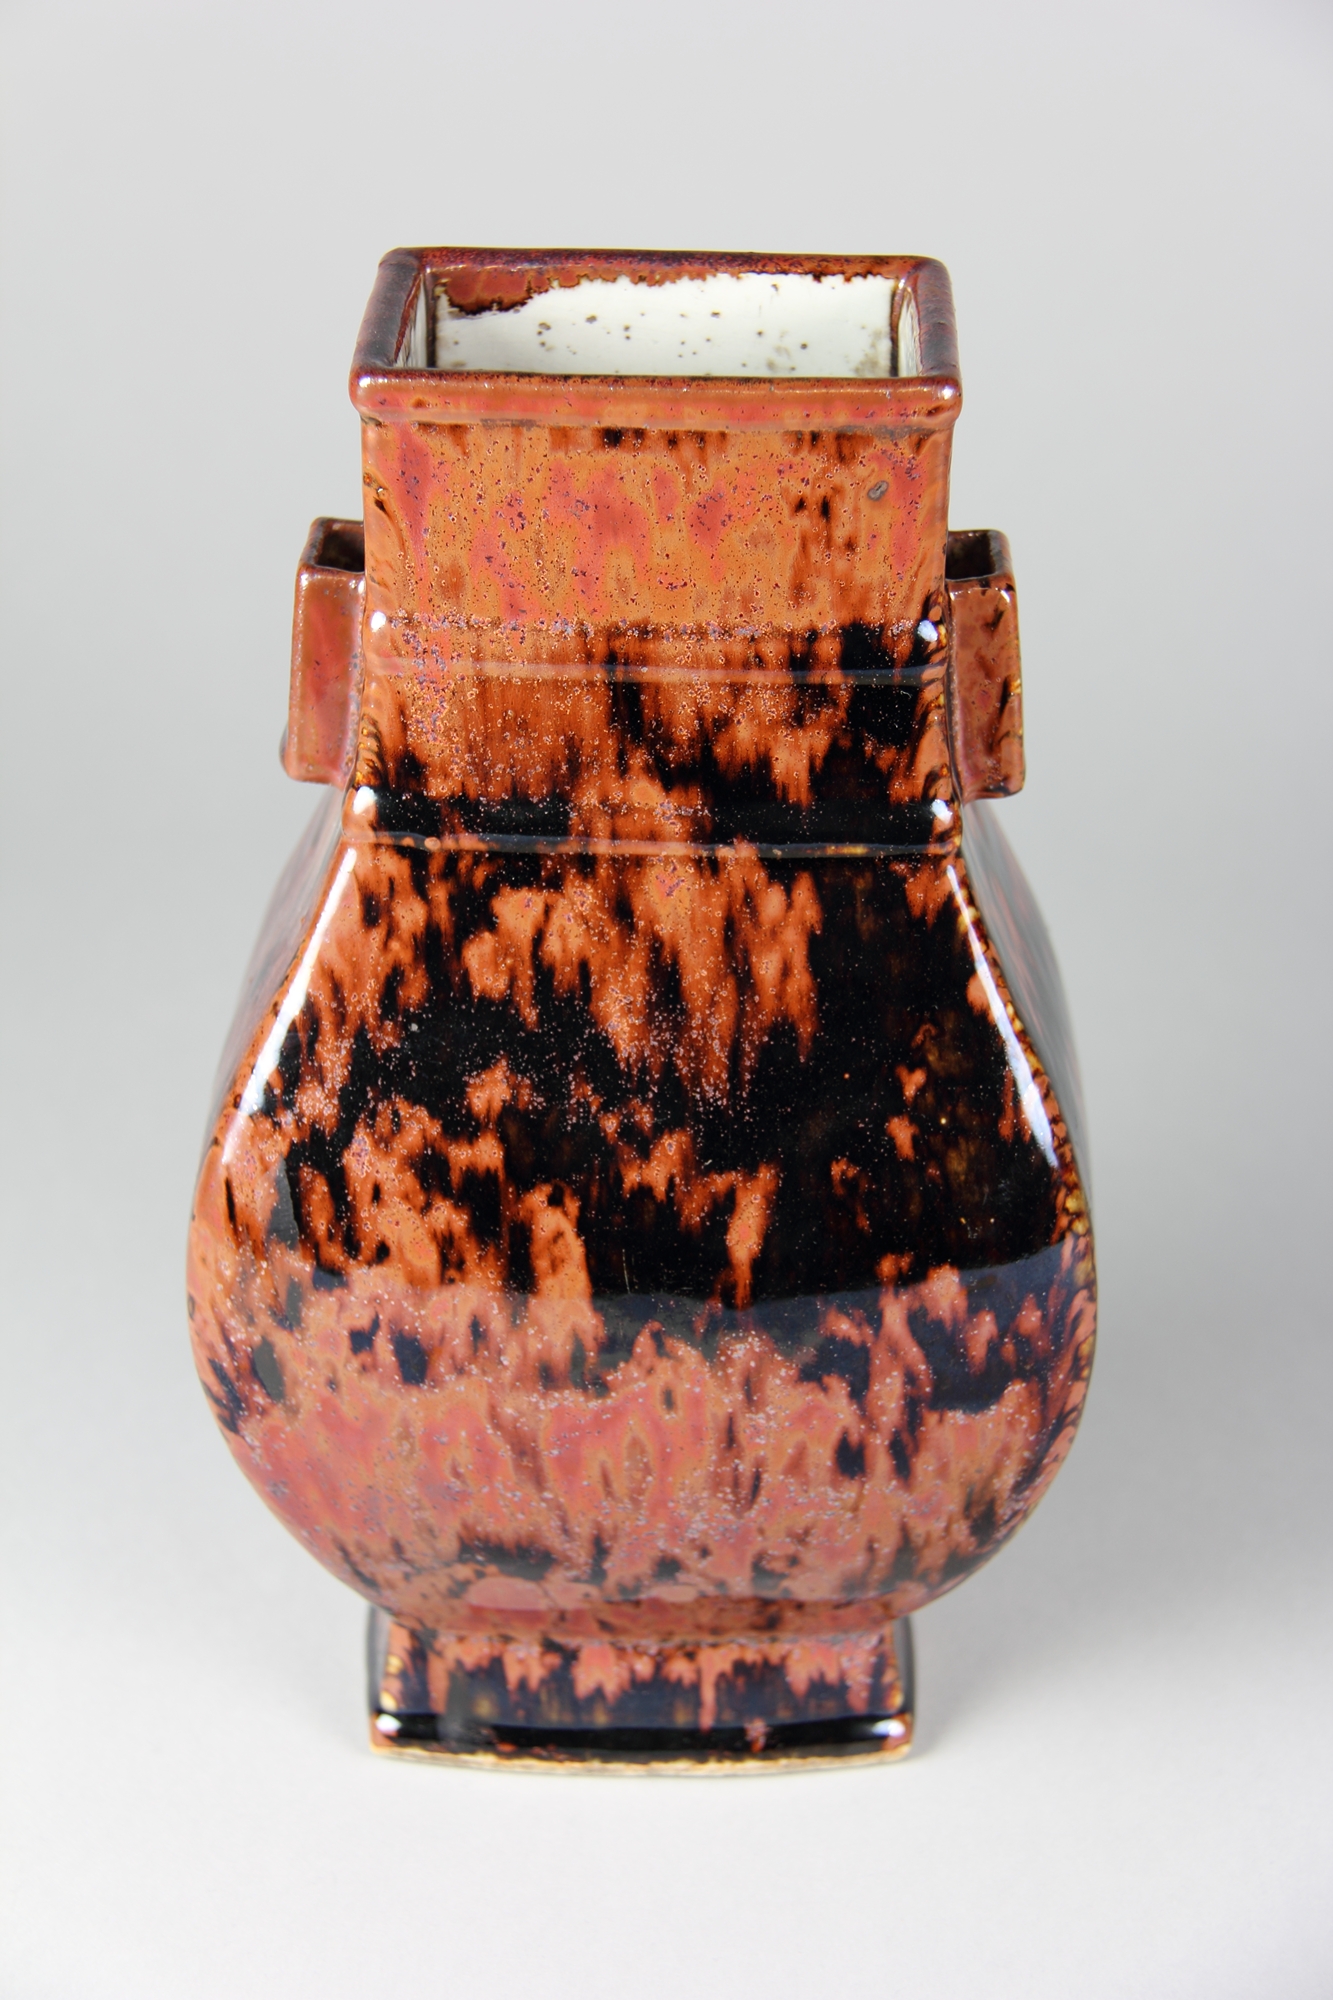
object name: vase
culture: chinese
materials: glaze, porcelain